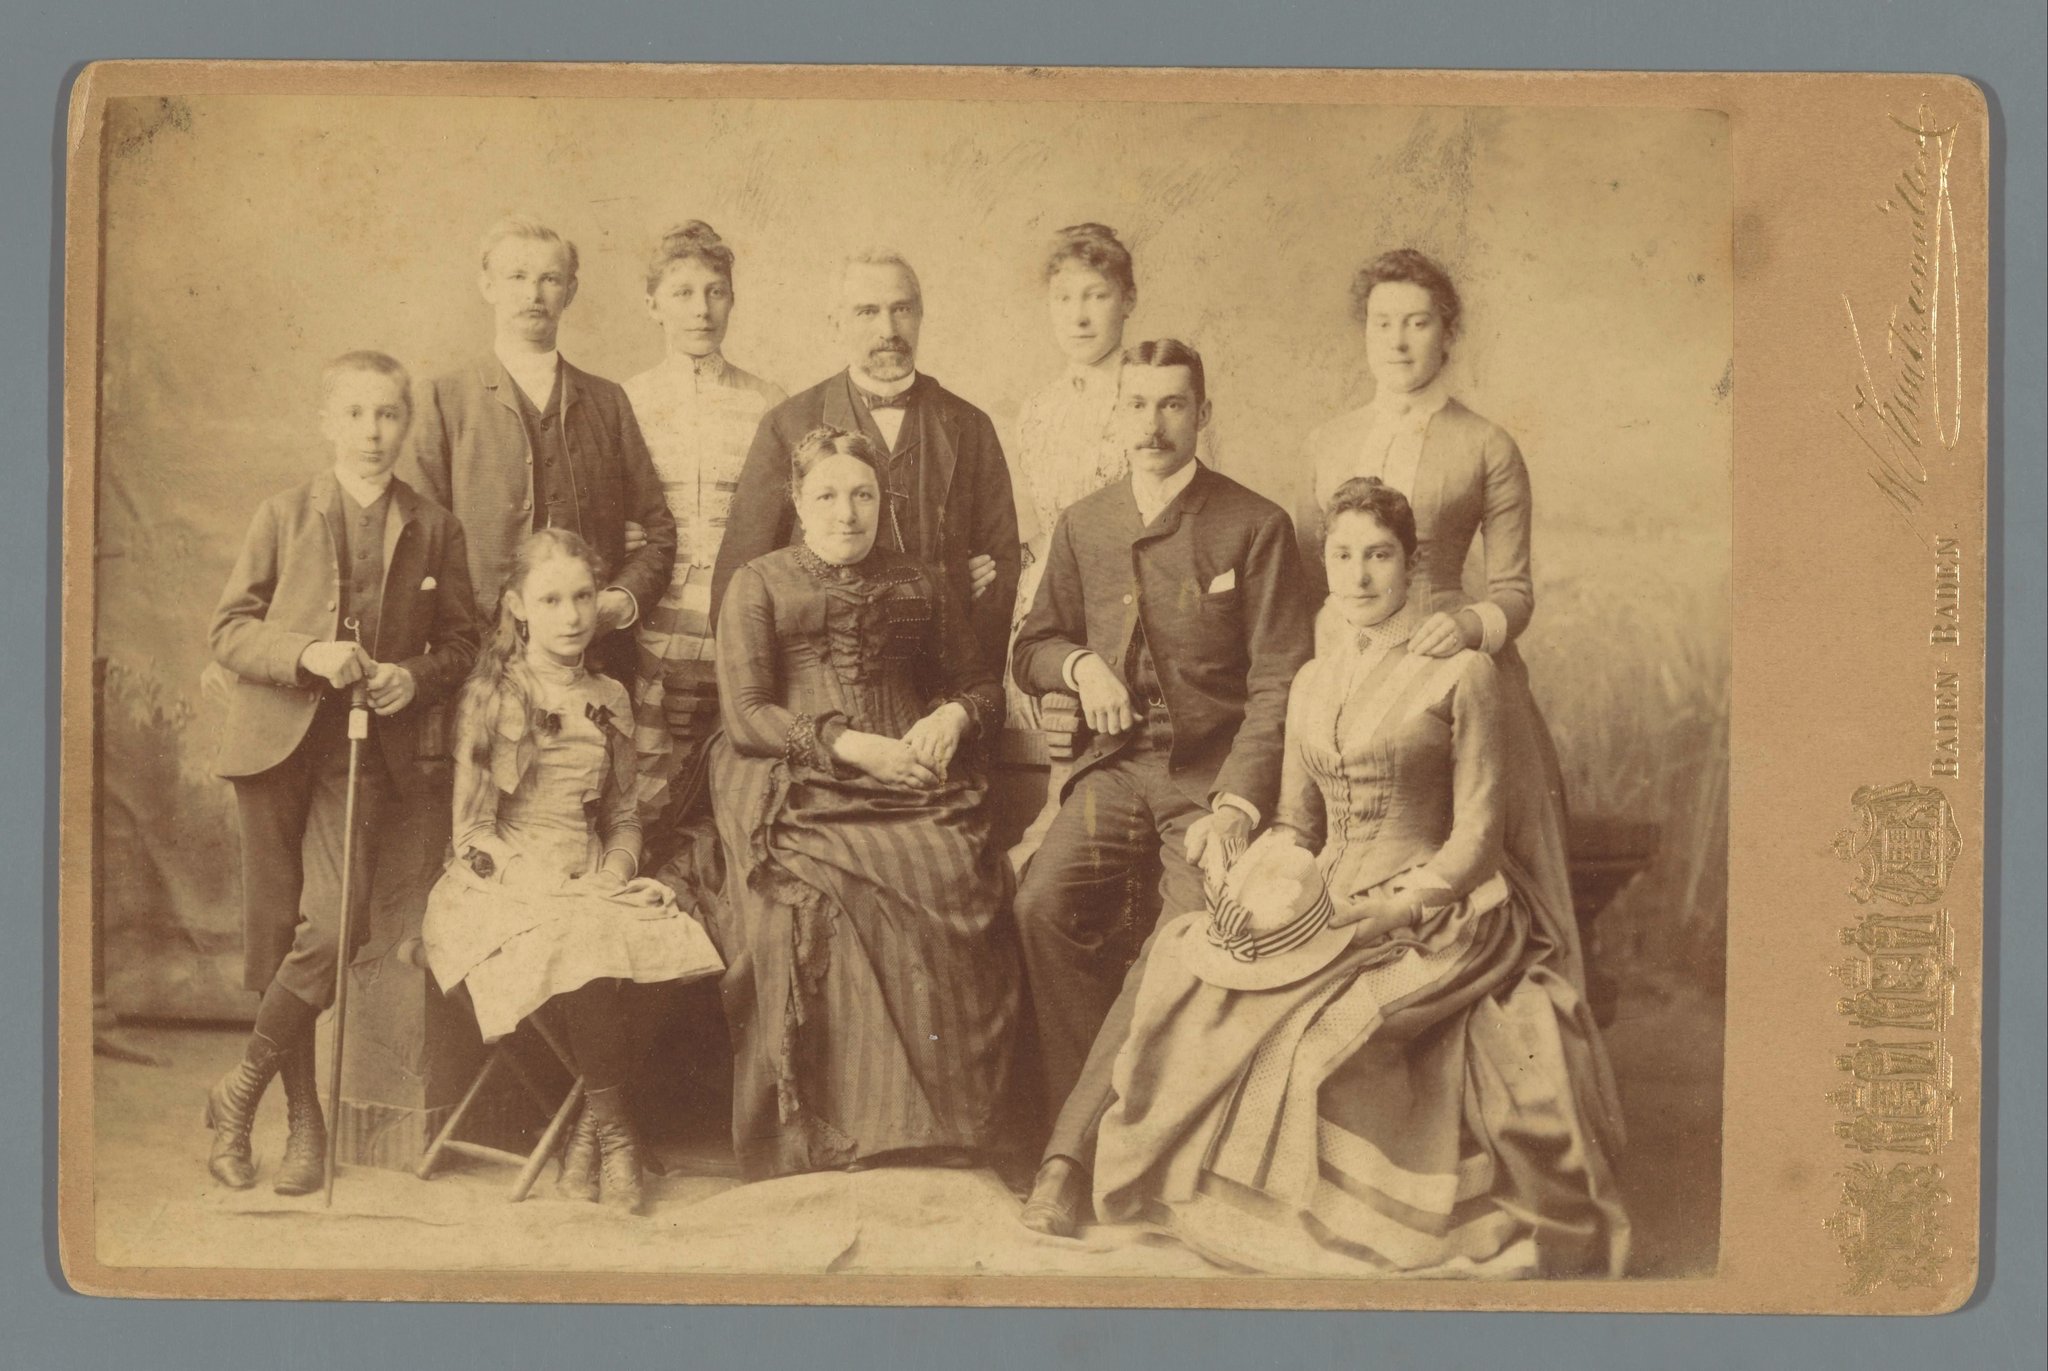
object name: cabinet photograph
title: Familieportret van de familie van Elst -den Bant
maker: wilhelm kuntzemüller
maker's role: fotograaf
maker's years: 1845-1918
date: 1876-1918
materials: cardboard, photographic support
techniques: albumen print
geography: baden-baden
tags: family, descendance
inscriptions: inscription: ‘familie v Elst- den Bant bij hun zilveren bruiloft te Baden-Baden’, name: ‘W. Kuntzemüller Hofphotograph Baden-Baden Friedrich-Str. No. 1, (...)’